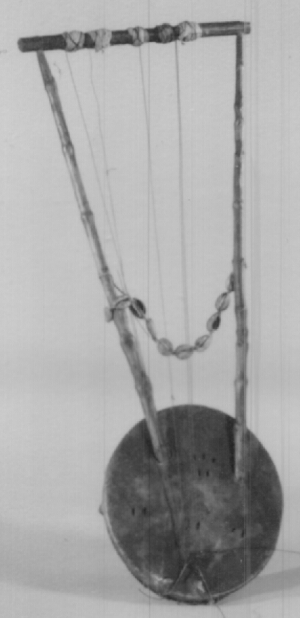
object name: kissar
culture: african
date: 1801-1900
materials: shell, skin, wood